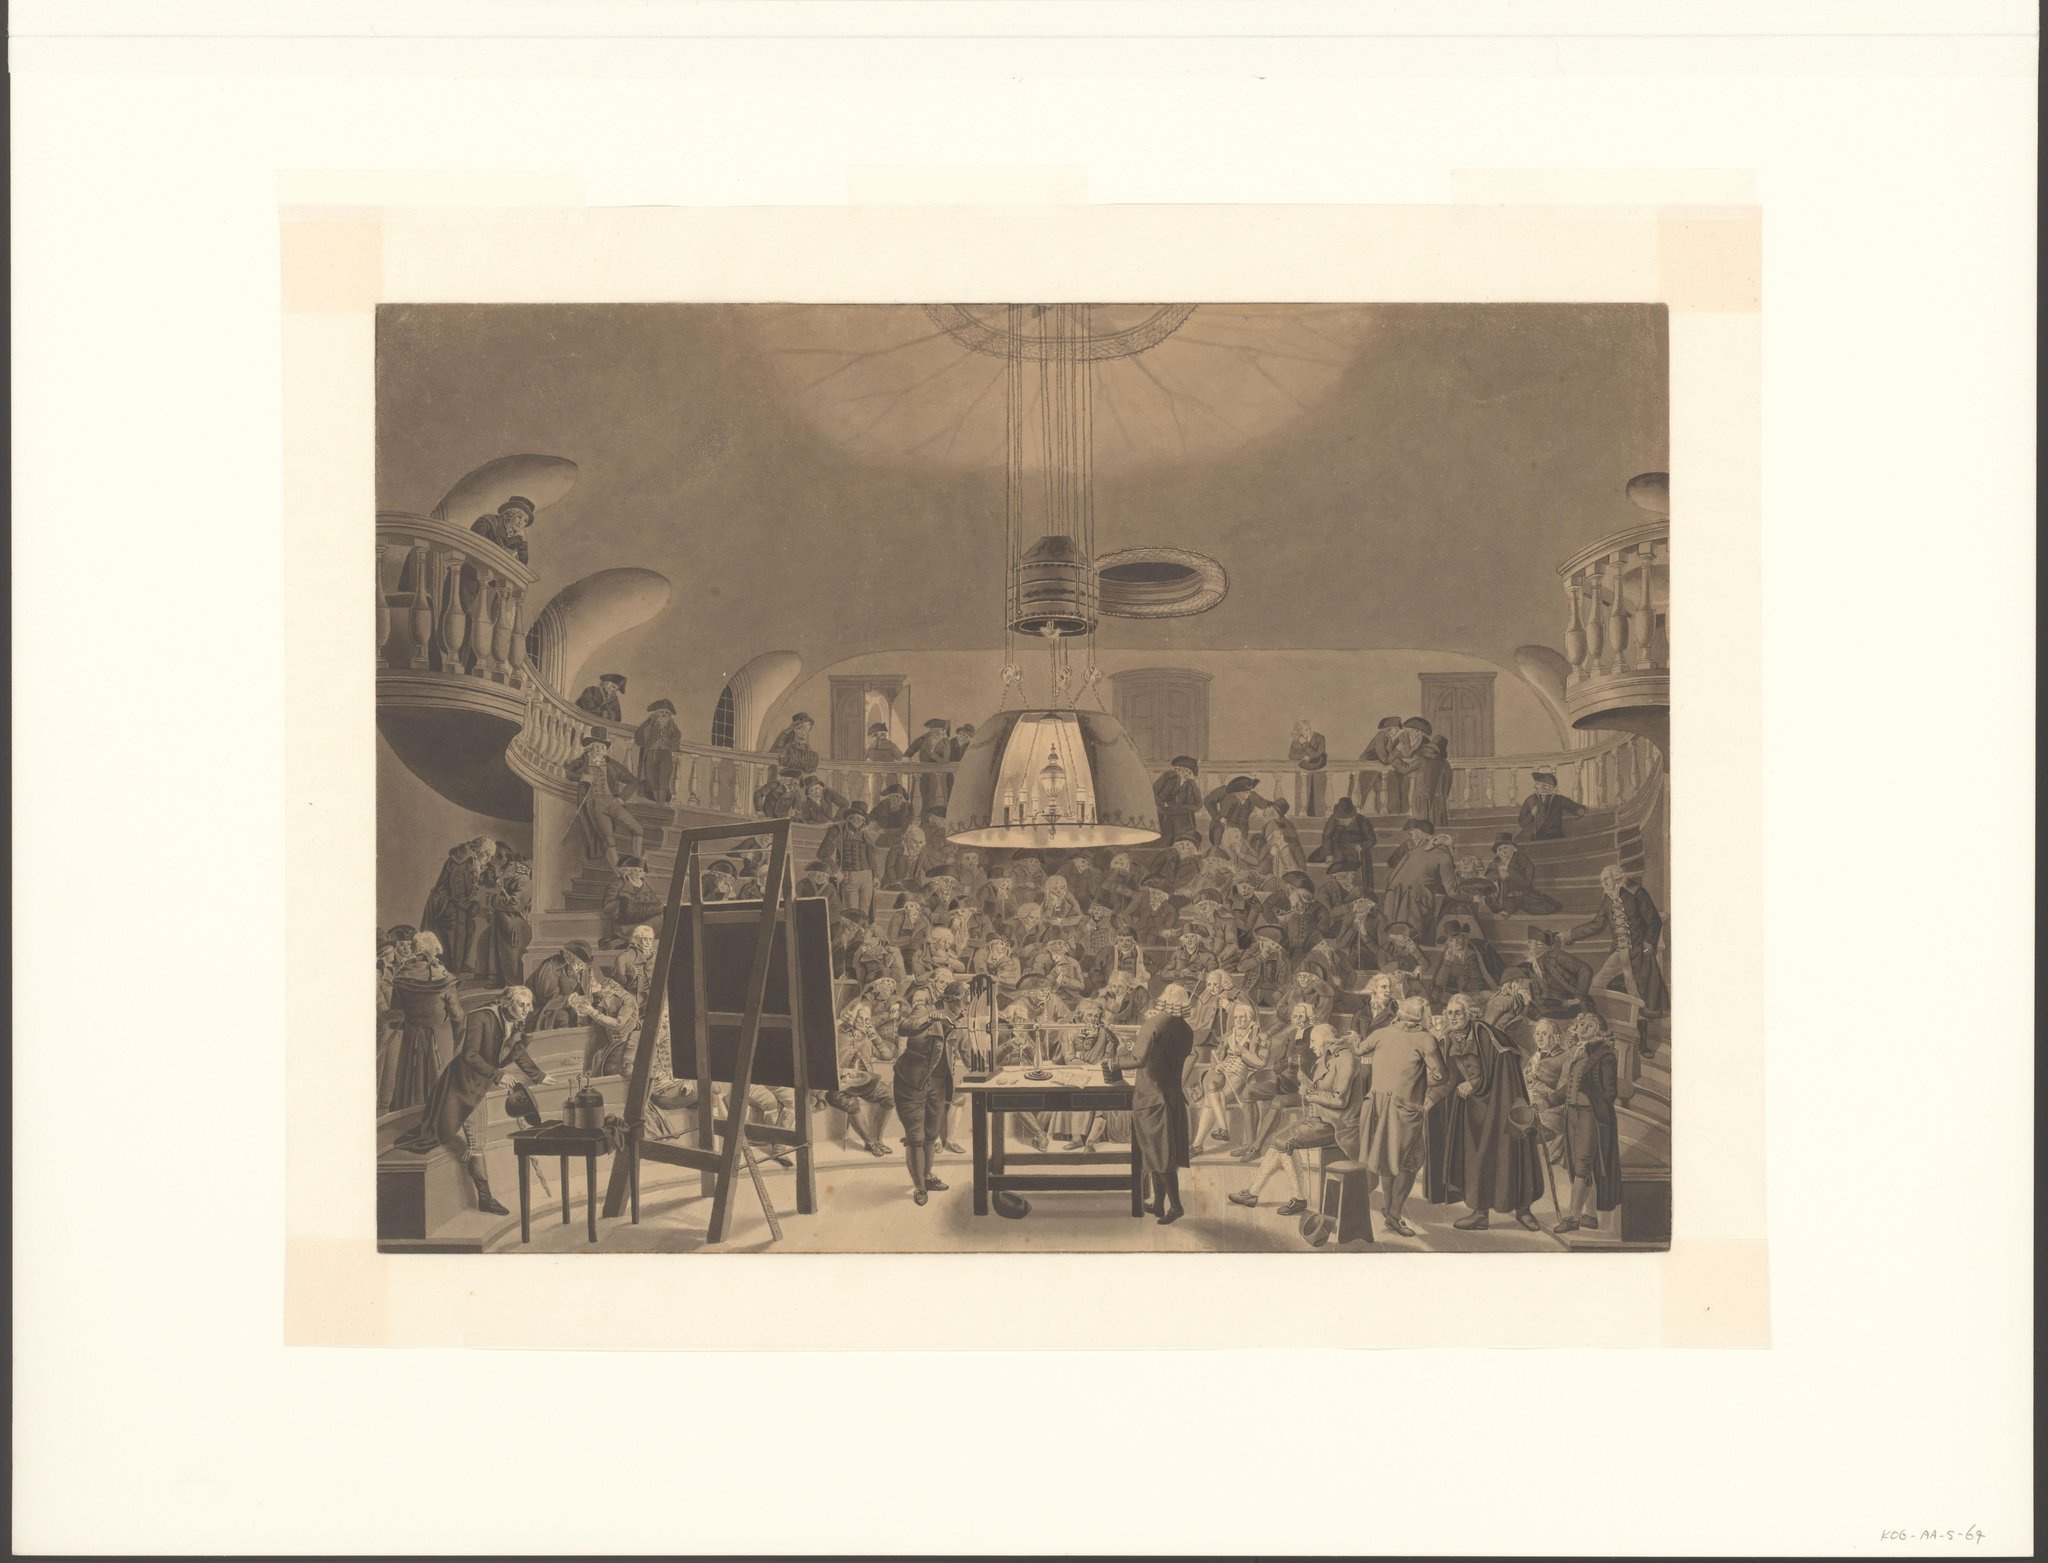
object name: drawing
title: Interieur van de Zaal der Natuurkunde in Felix Meritis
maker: mathijs frederik binquebanc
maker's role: amateurschilder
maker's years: 1793-1870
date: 1817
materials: ink, paper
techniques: brush, pen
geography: amsterdam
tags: physics, power station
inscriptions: signature and date: ‘M.F:Binquebanc fec 1812.-’, number: ‘2’